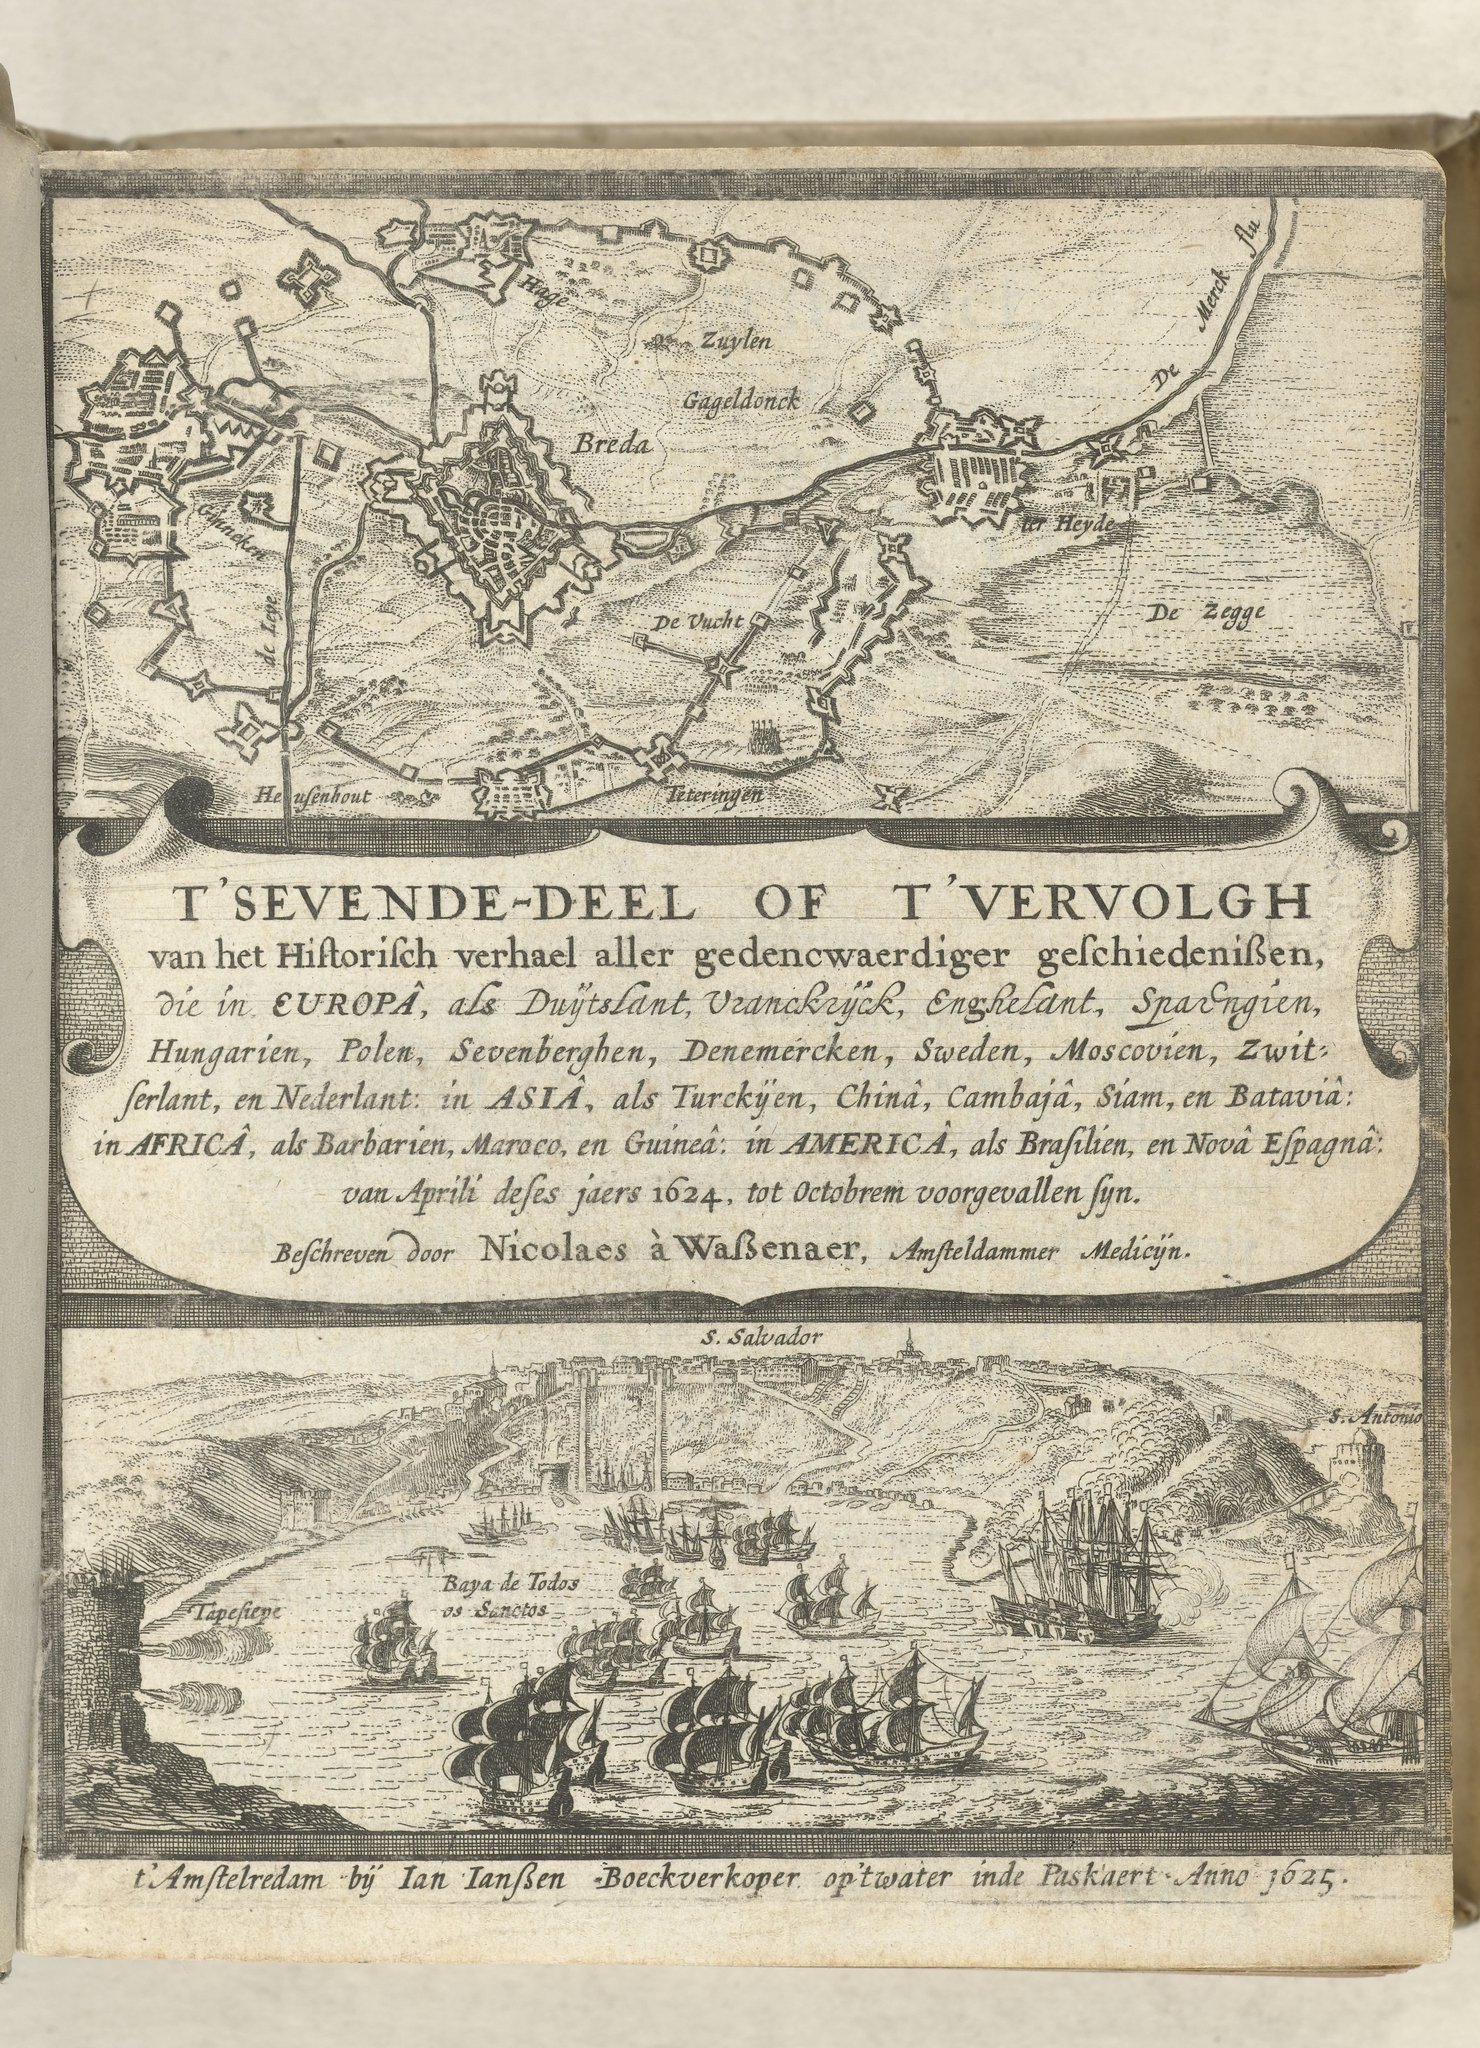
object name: print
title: Titelblad van Historisch verhael, band 3 (dl. 7), 1624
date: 1624-1625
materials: paper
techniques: etching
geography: northern netherlands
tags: amsterdam, maps of separate countries or regions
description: Titelblad van Historisch verhael, band 3 (dl. 7), 1624. Titelblad met twee voorstellingen. Boven een kaart van Breda en omgeving. Onder de verovering van San Salvador in Brazilië door de West-Indische vloot onder admiraal Jacob Willekens, 10 mei 1624. In het midden een cartouche met de titel.